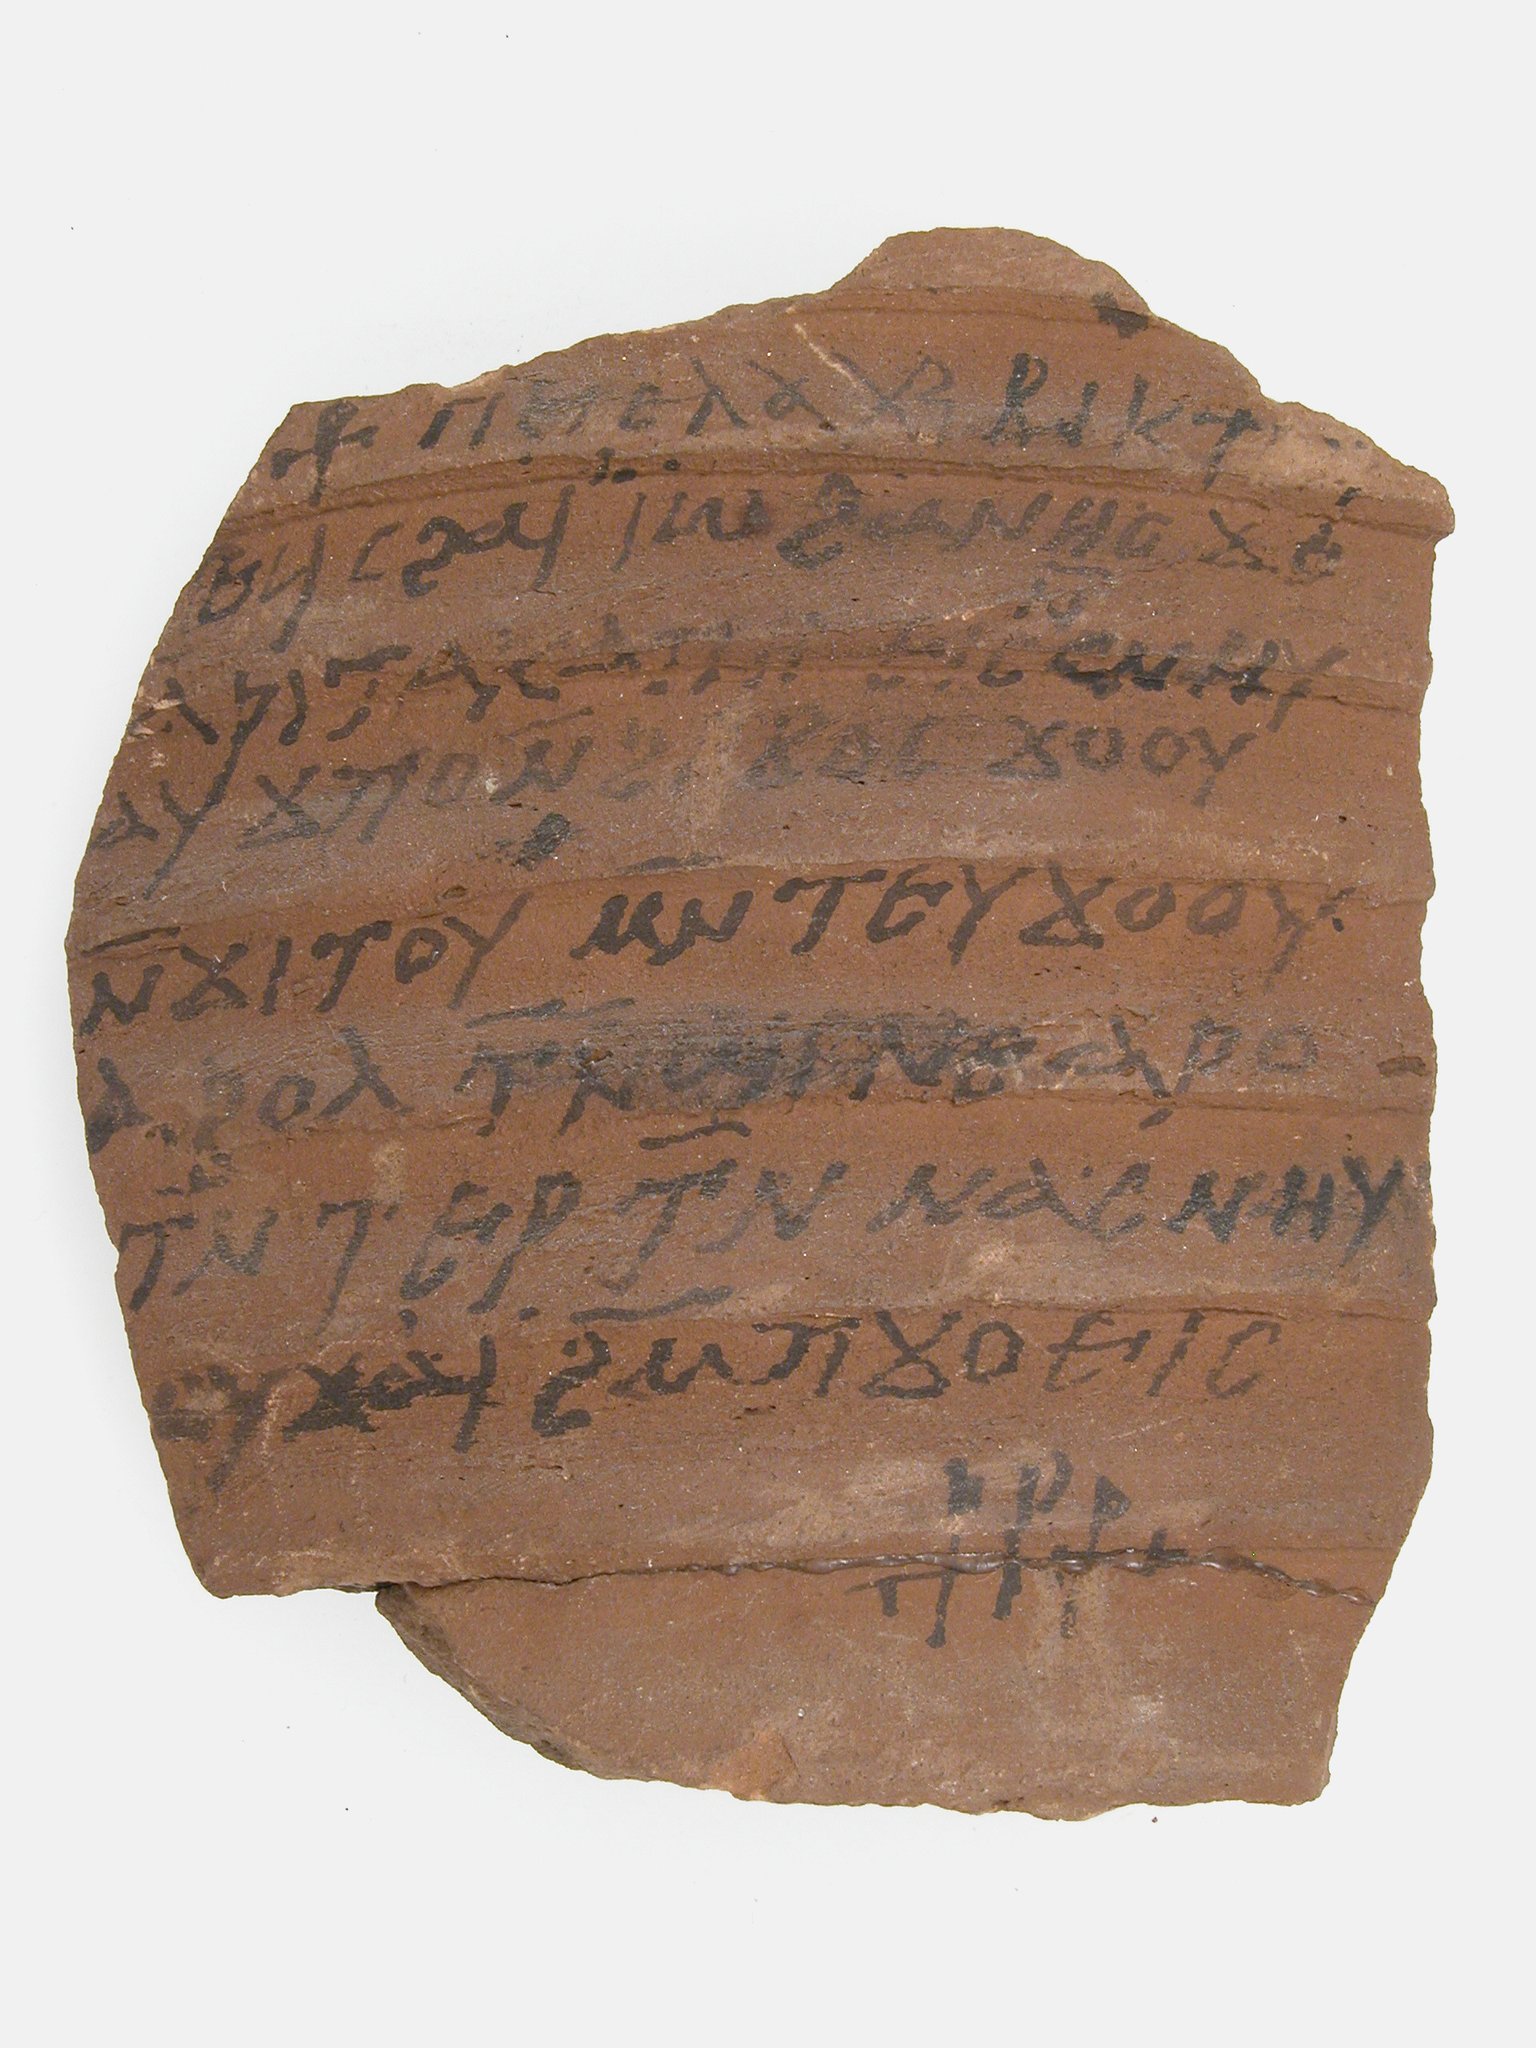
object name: ostrakon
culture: coptic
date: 601-700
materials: ink, pottery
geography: egypt